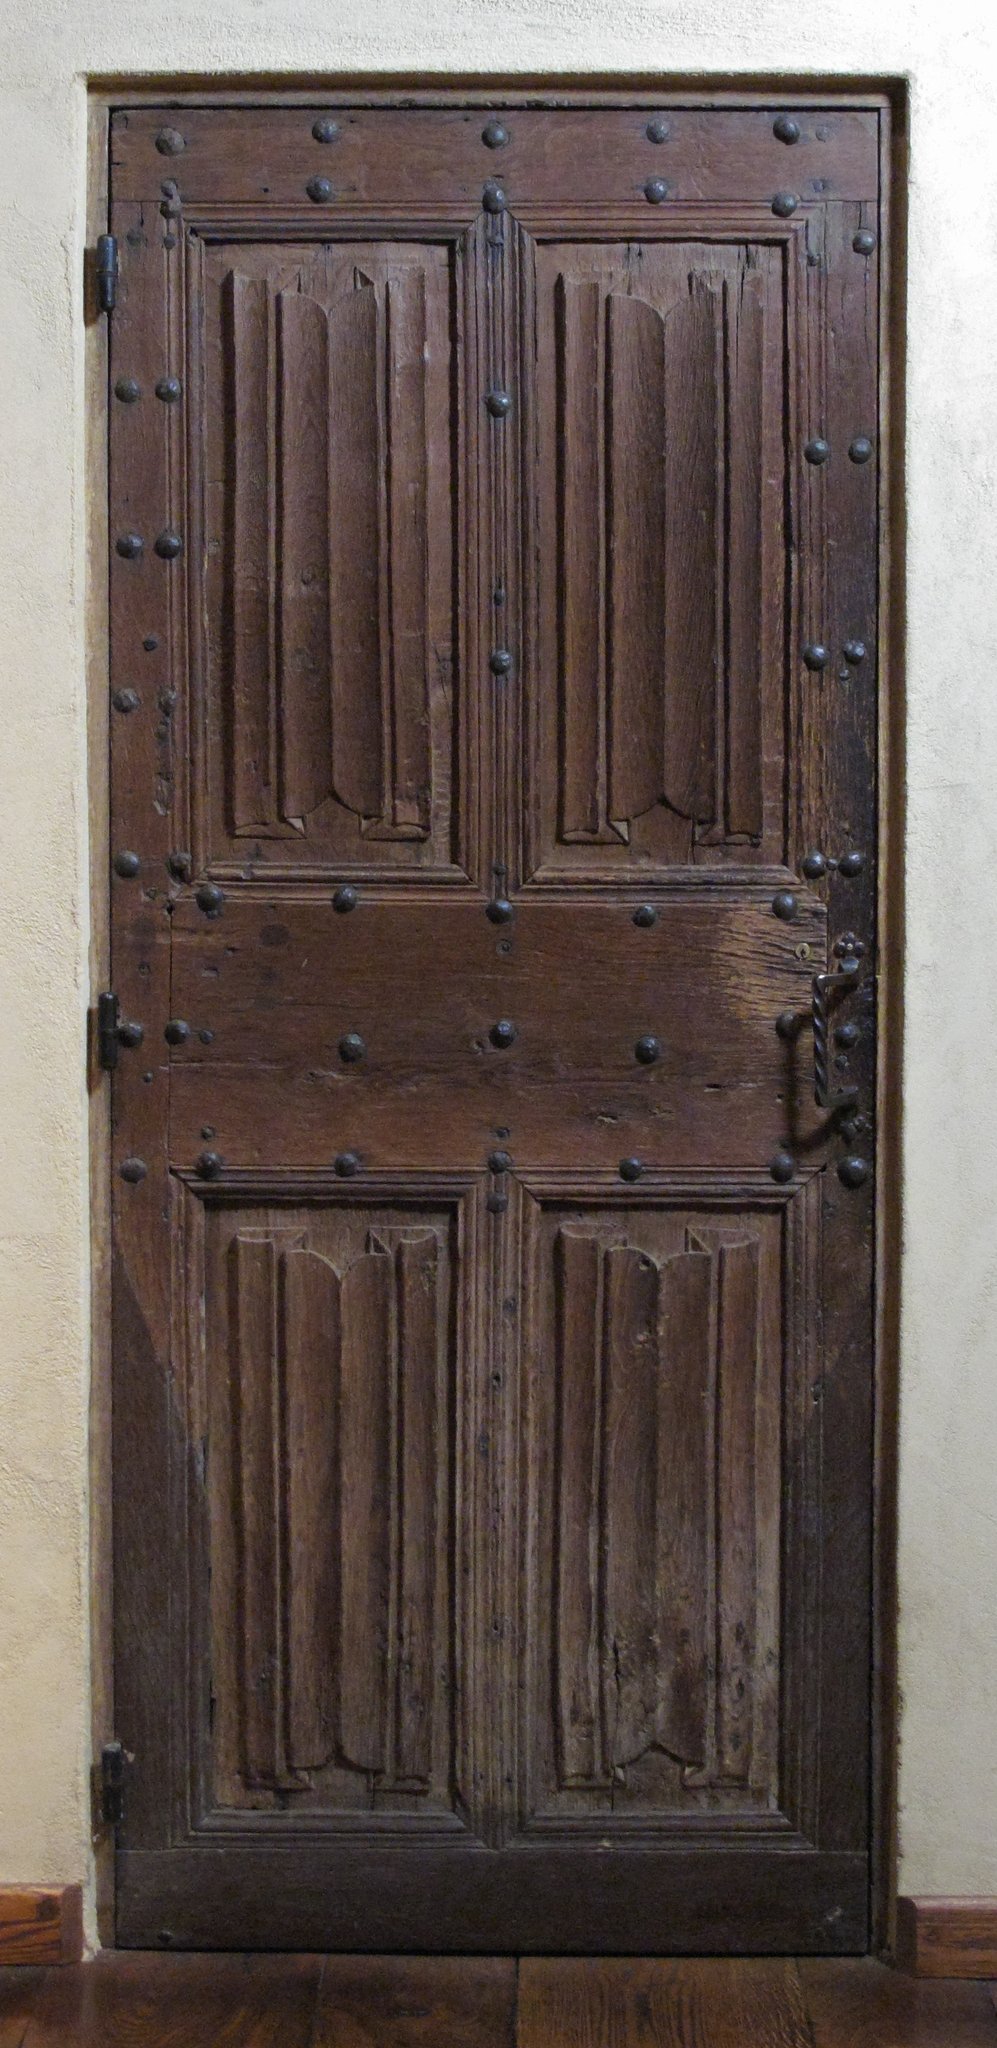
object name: door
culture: french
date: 1467-1500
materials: wood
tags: doors